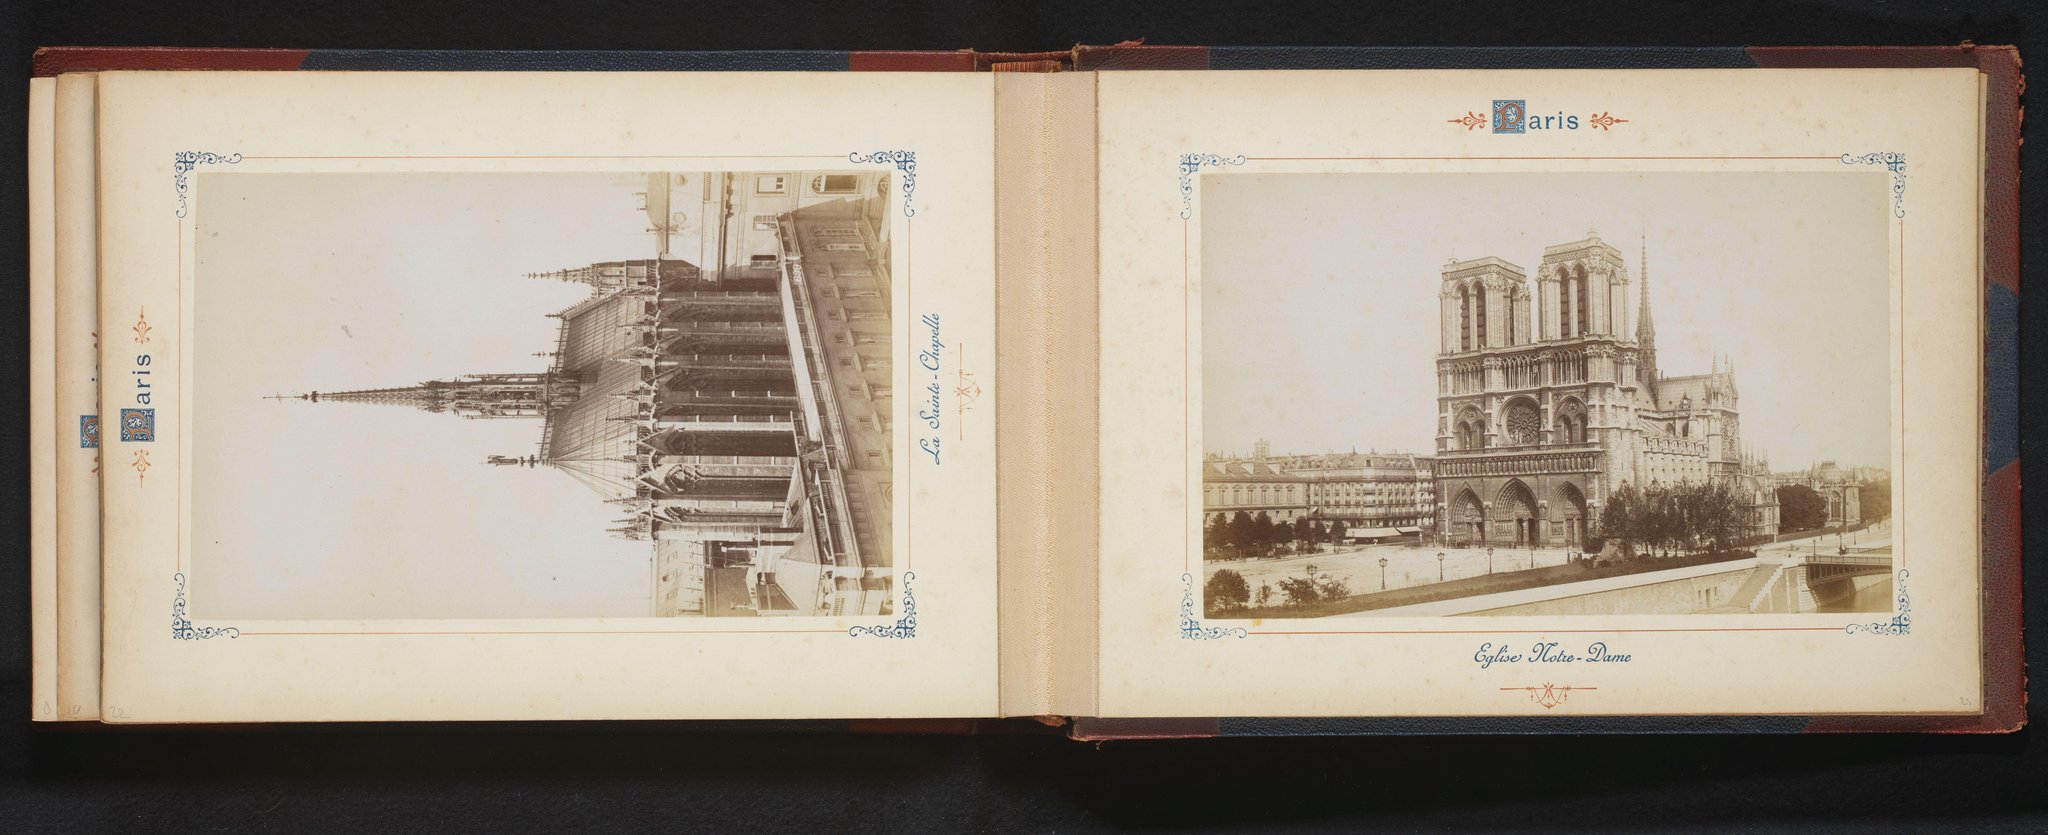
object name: page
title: La Sainte-Chapelle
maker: Anonymous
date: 1879-1889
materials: photographic support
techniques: albumen print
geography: paris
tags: church (exterior) - qq - small church, chapel, façade (of house or building)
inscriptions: number: ‘639’